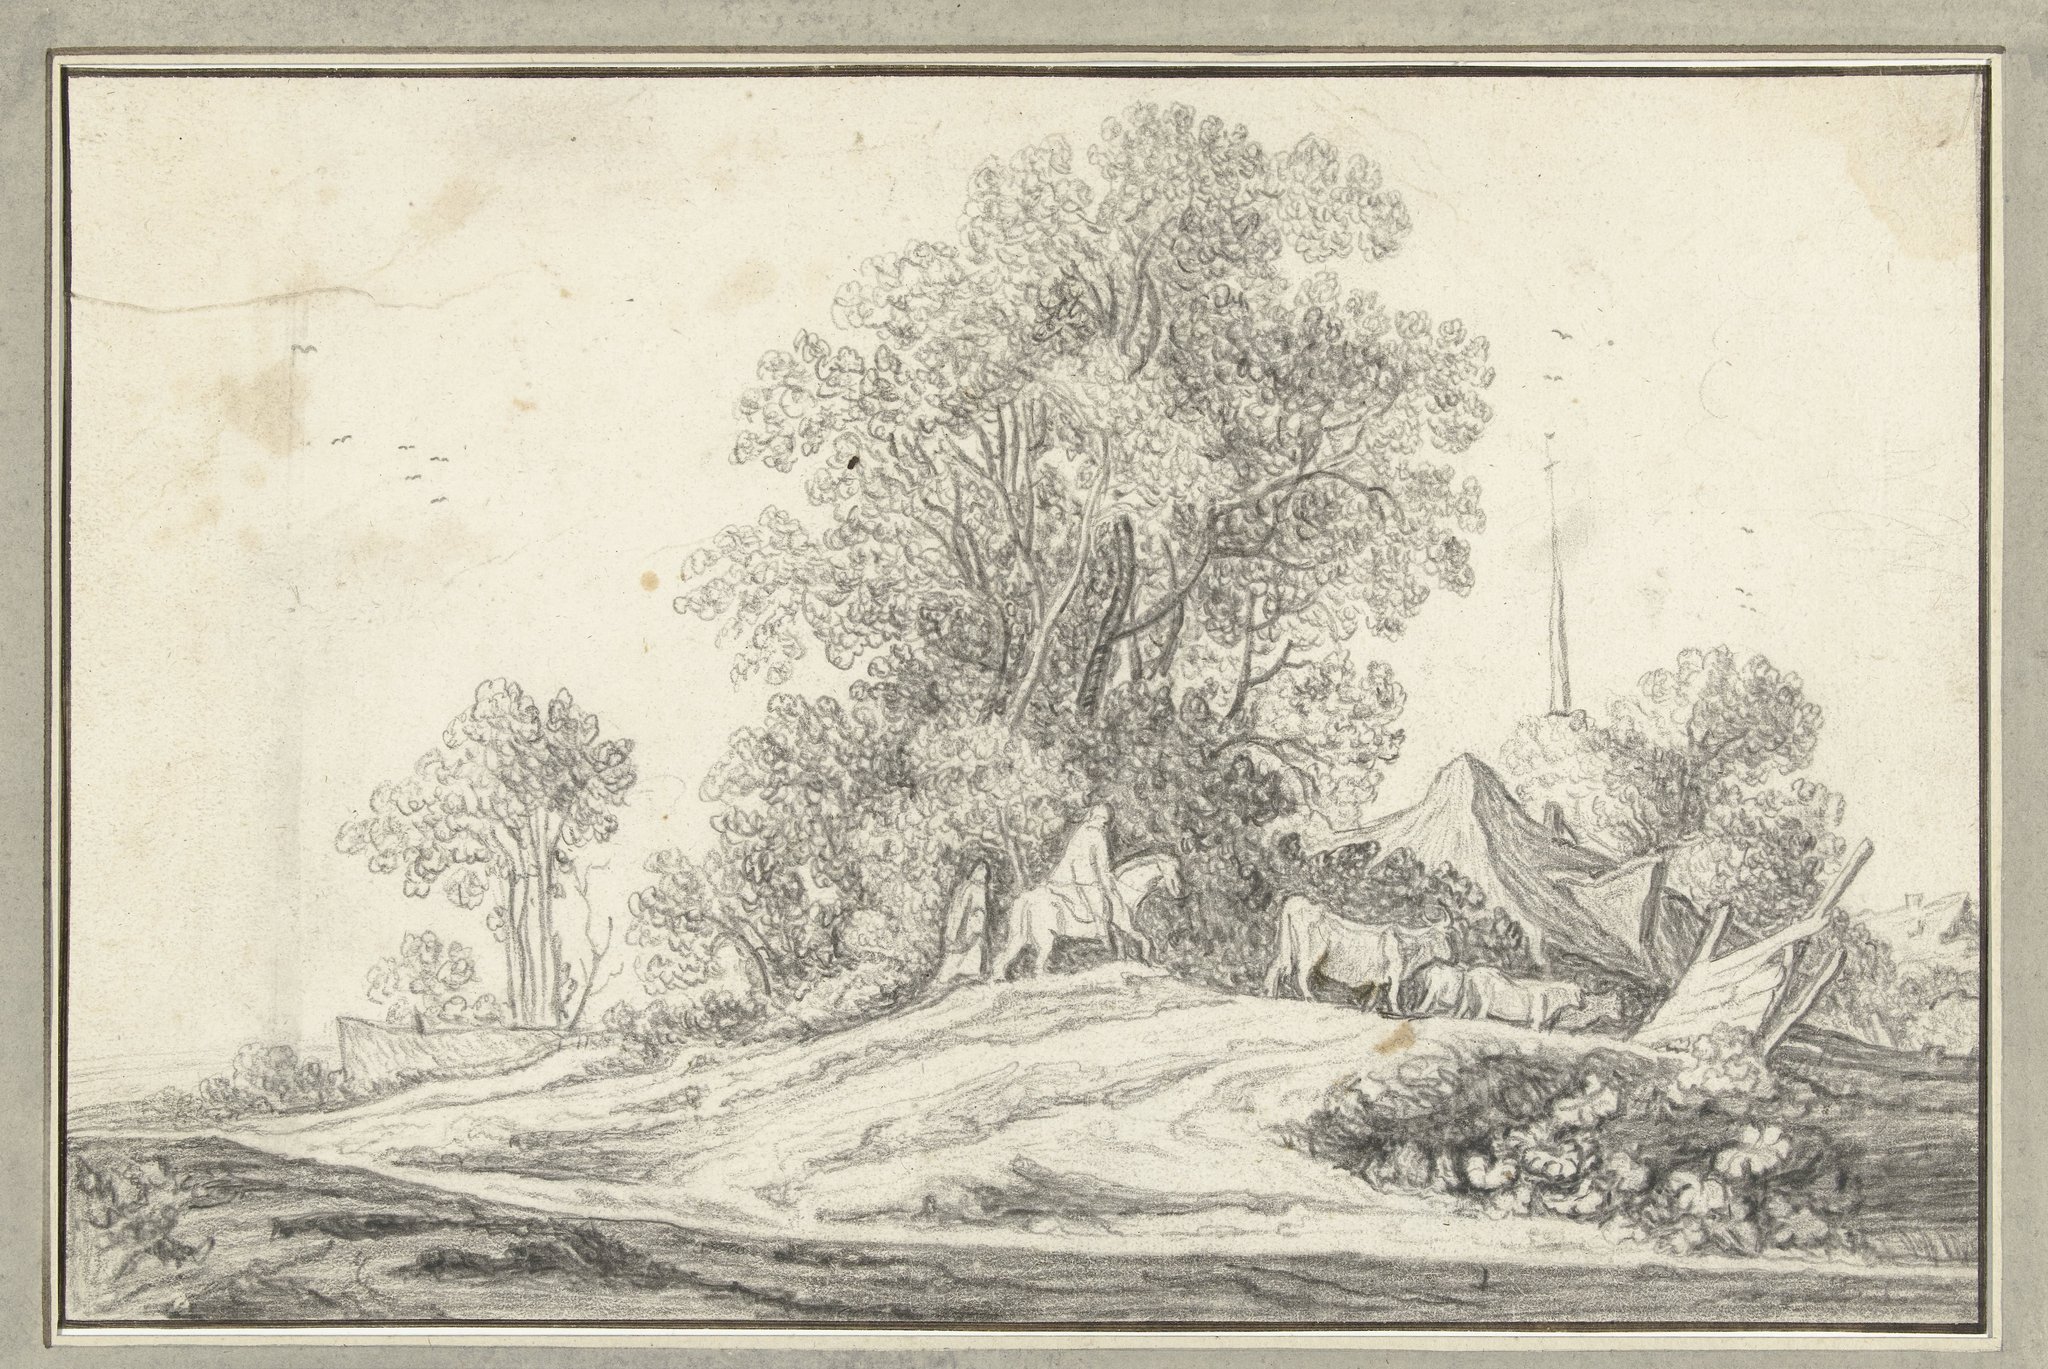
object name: drawing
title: Landschap met een ruiter en koeien voor een boomgroep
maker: Anonymous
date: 1600-1635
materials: chalk, paper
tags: city-view, and landscape with man-made constructions